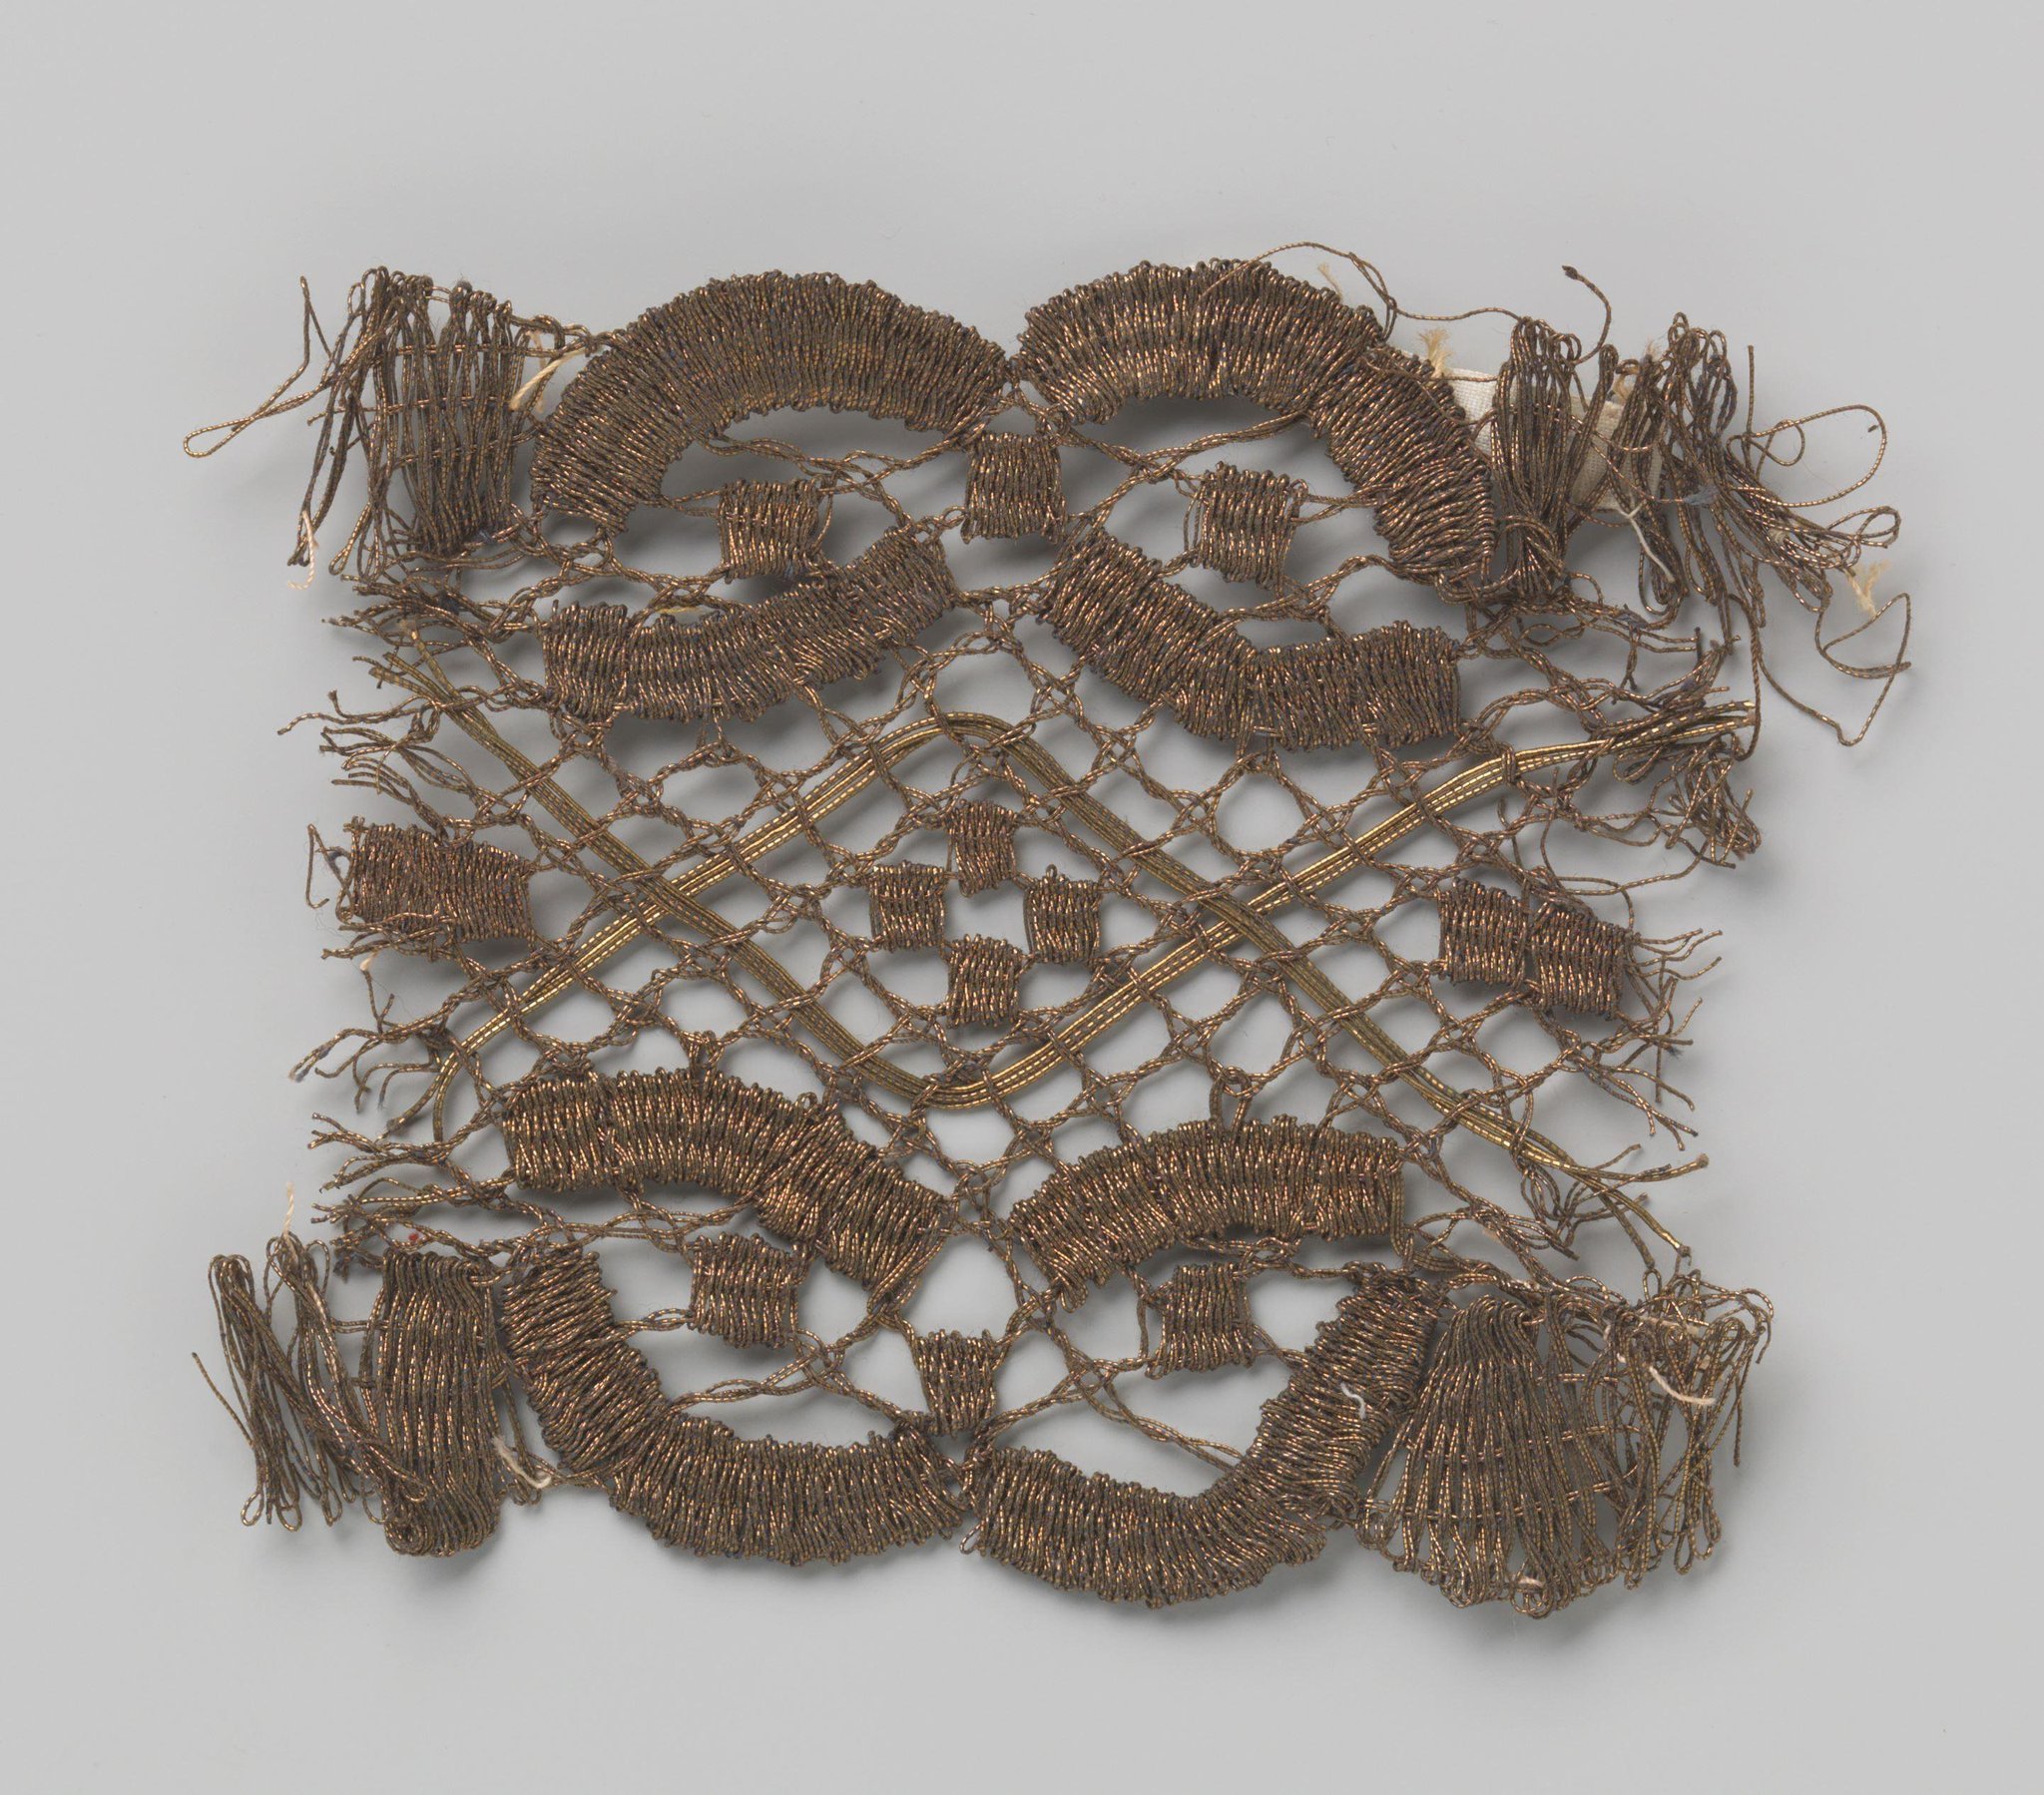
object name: strip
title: Strook goudkant met vierkantjes in een ruit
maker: Anonymous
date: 1925-1930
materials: gold thread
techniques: lace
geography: volvic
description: Strook kloskant, goudkant, Cluny-kant. Het patroon is geïnspireerd op zestiende eeuwse goudkanten en bestaat uit een ruit op de middenlijn, gevormd door elkaar kruisende lijnen. In de ruit staat een configuratie van vier vierkantjes. Langs de boven- en onderrand staan twee tegen elkaar aan geplaatste ovalen, elk gevormd door twee dikke boogjes, met in het centrum een vierkantje. De boogjes en vierkantjes zijn gemaakt in vormslag en zijn met elkaar verbonden door een maasgrond, een vetergatslag-traliegrond. De lijnen die de ruit vormen, bestaan uit drie naast elkaar liggende draden, die tussen de dunnere draden steken waarmee de mazen zijn gevormd. De boogjes vormen schulpen aan beide lange zijden van de strook.